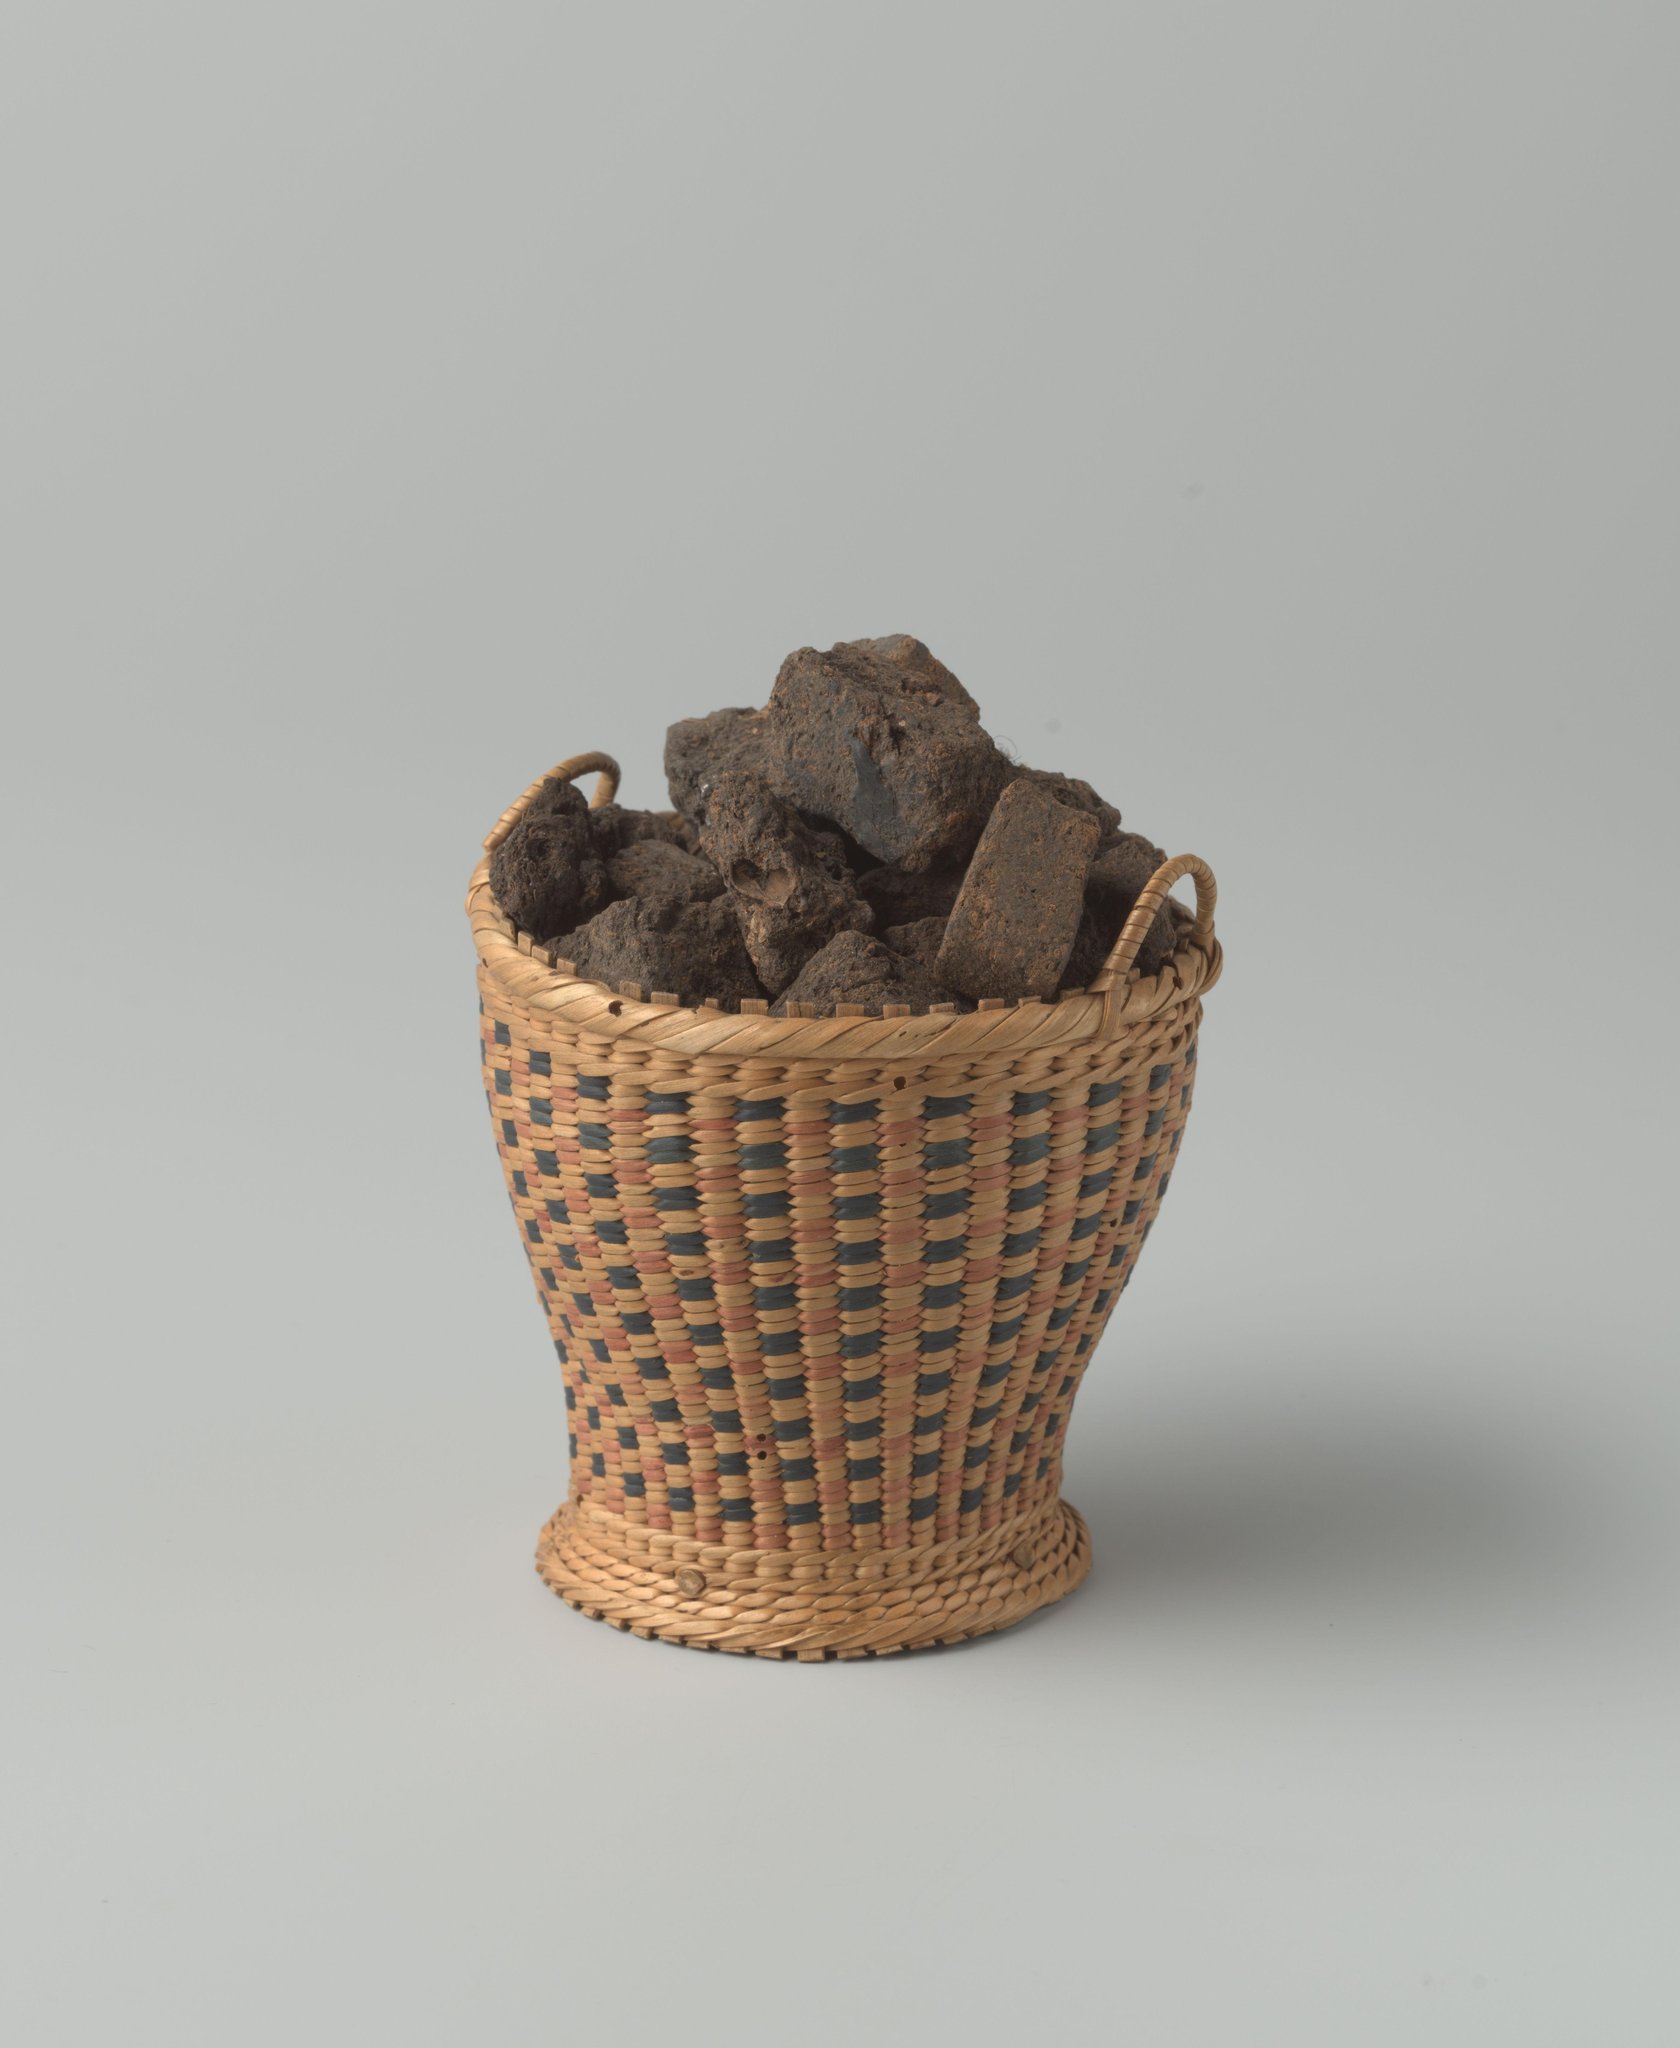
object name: turfmand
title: Turfmand met turf, vervaardigd van gespleten wilgenteen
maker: Anonymous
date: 1676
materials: plant material, peat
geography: halle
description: Turfmand, rond, iets bol uitlopend, van gespleten wilgenteen, in de techniek van het fijnscheenwerk. Naturelkleurige tenen zijn afgewisseld met zwart gebeitste tenen. Op de rand twee handvatten. De mand is gevuld met blokkken echte turf.